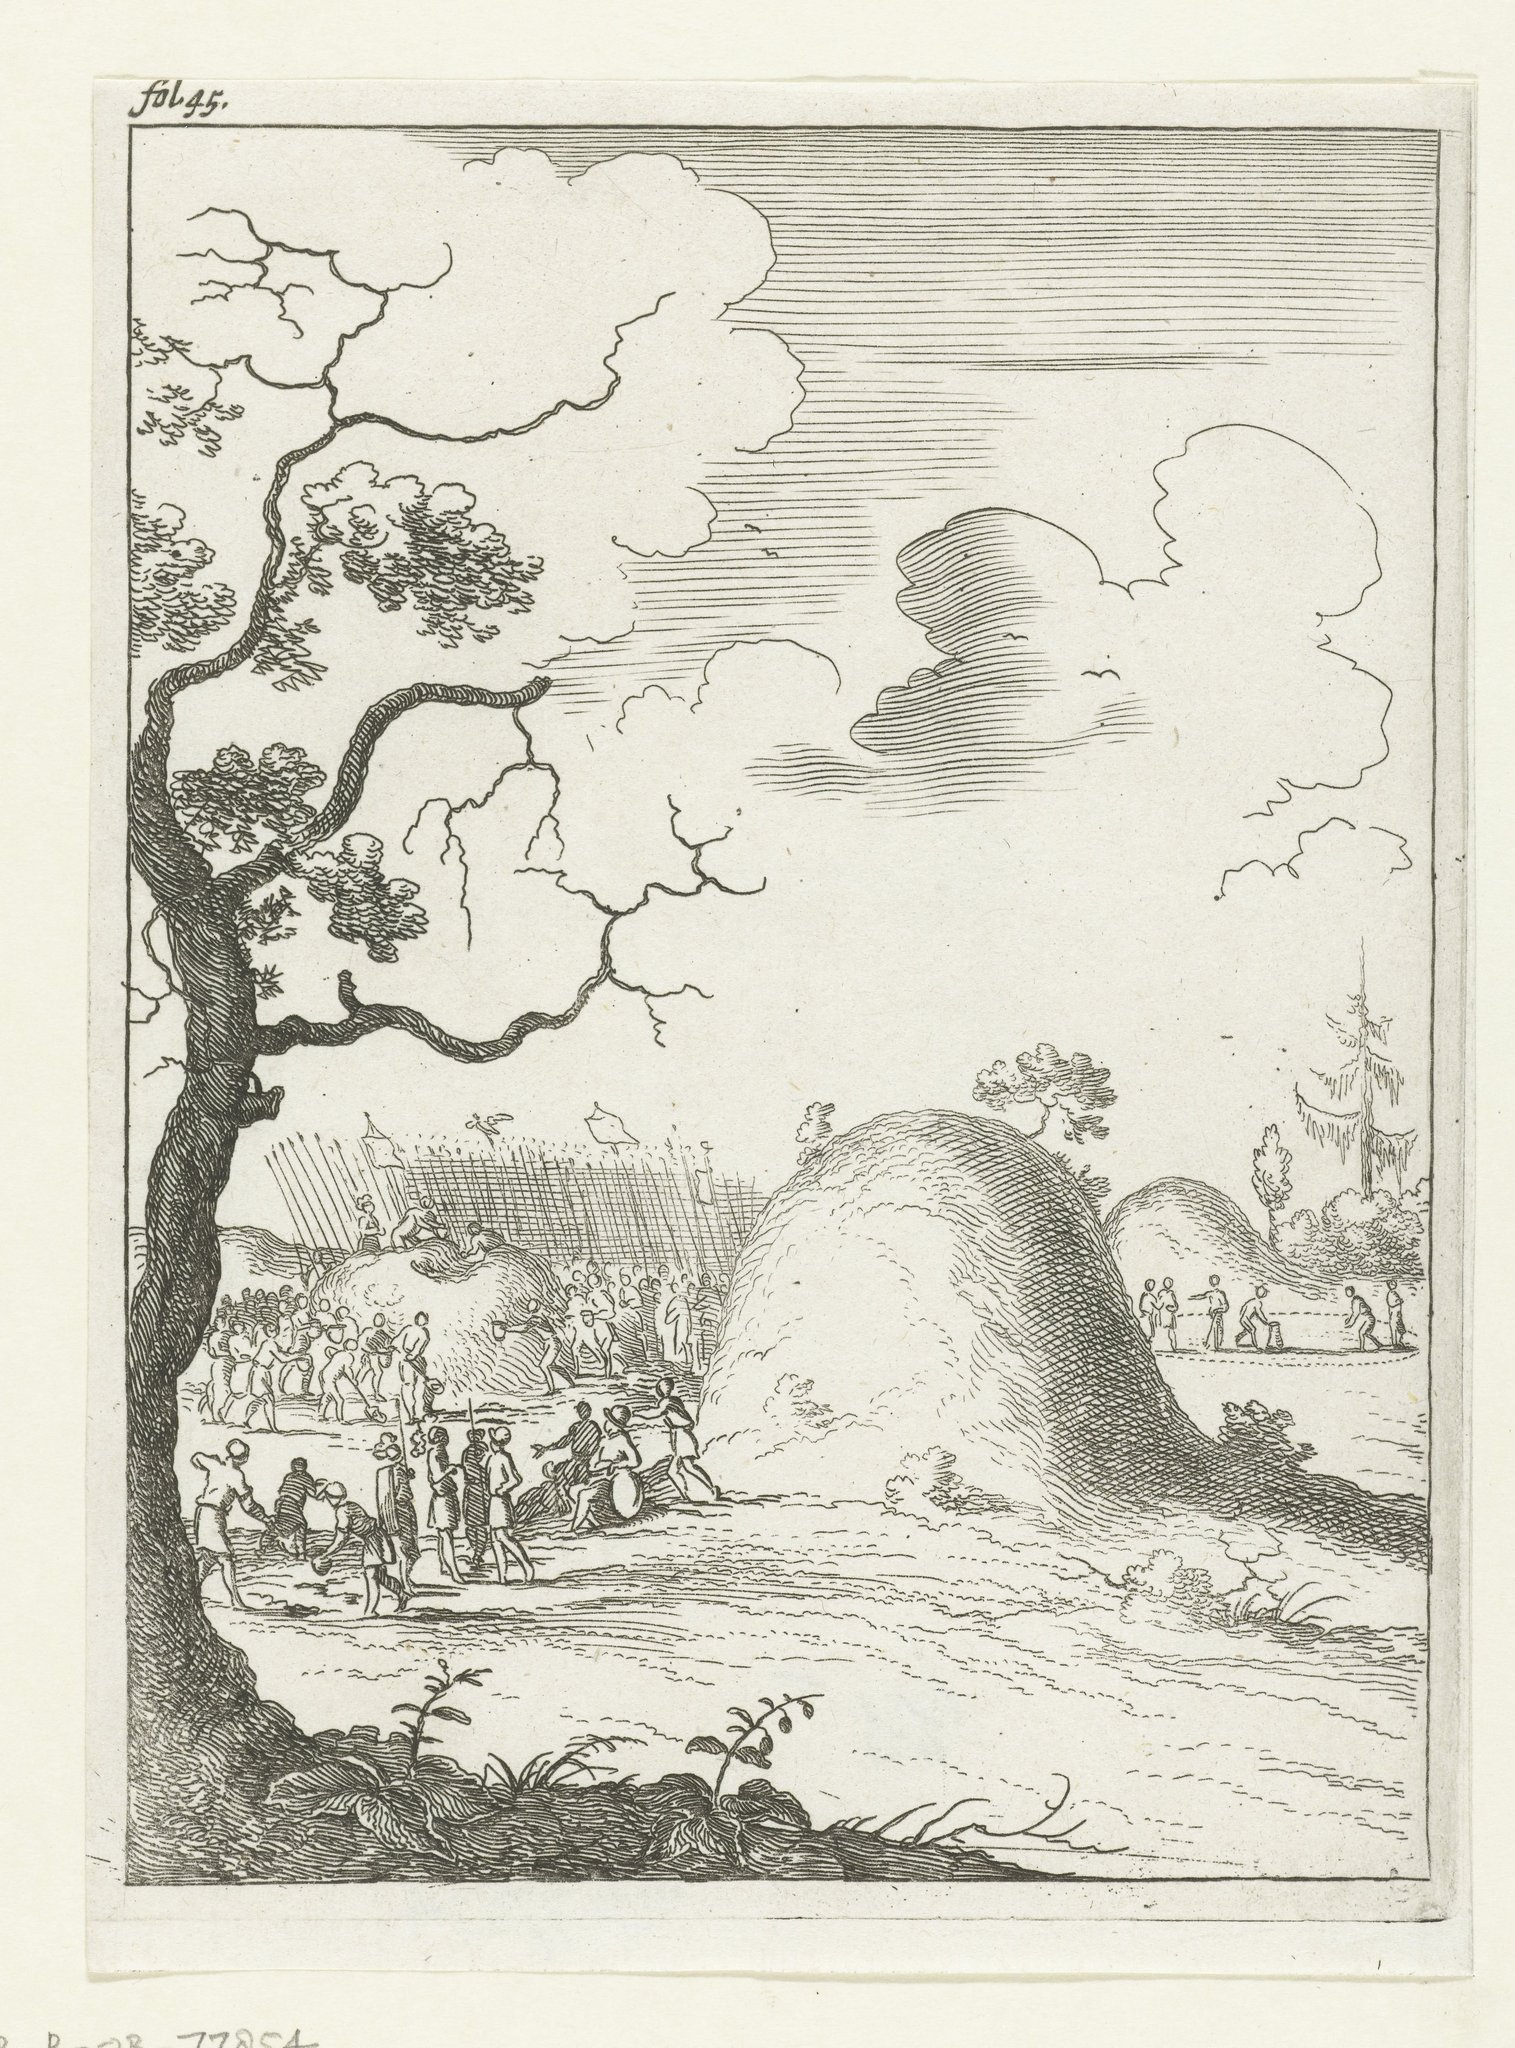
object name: historical object representation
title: Constructie van grafheuvels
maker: Anonymous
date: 1658-1660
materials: paper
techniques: etching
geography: netherlands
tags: burial mound, netherlands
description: Constructie van grafheuvels. Maakt deel uit van de acht illustraties in: Johan Picardt, Korte beschryvinge van eenige vergetene en verborgene antiquiteten … in het antiquiteet-rijcke landschap Drenth, Tymon Houthaak, Amsterdam 1660, fol. 45.